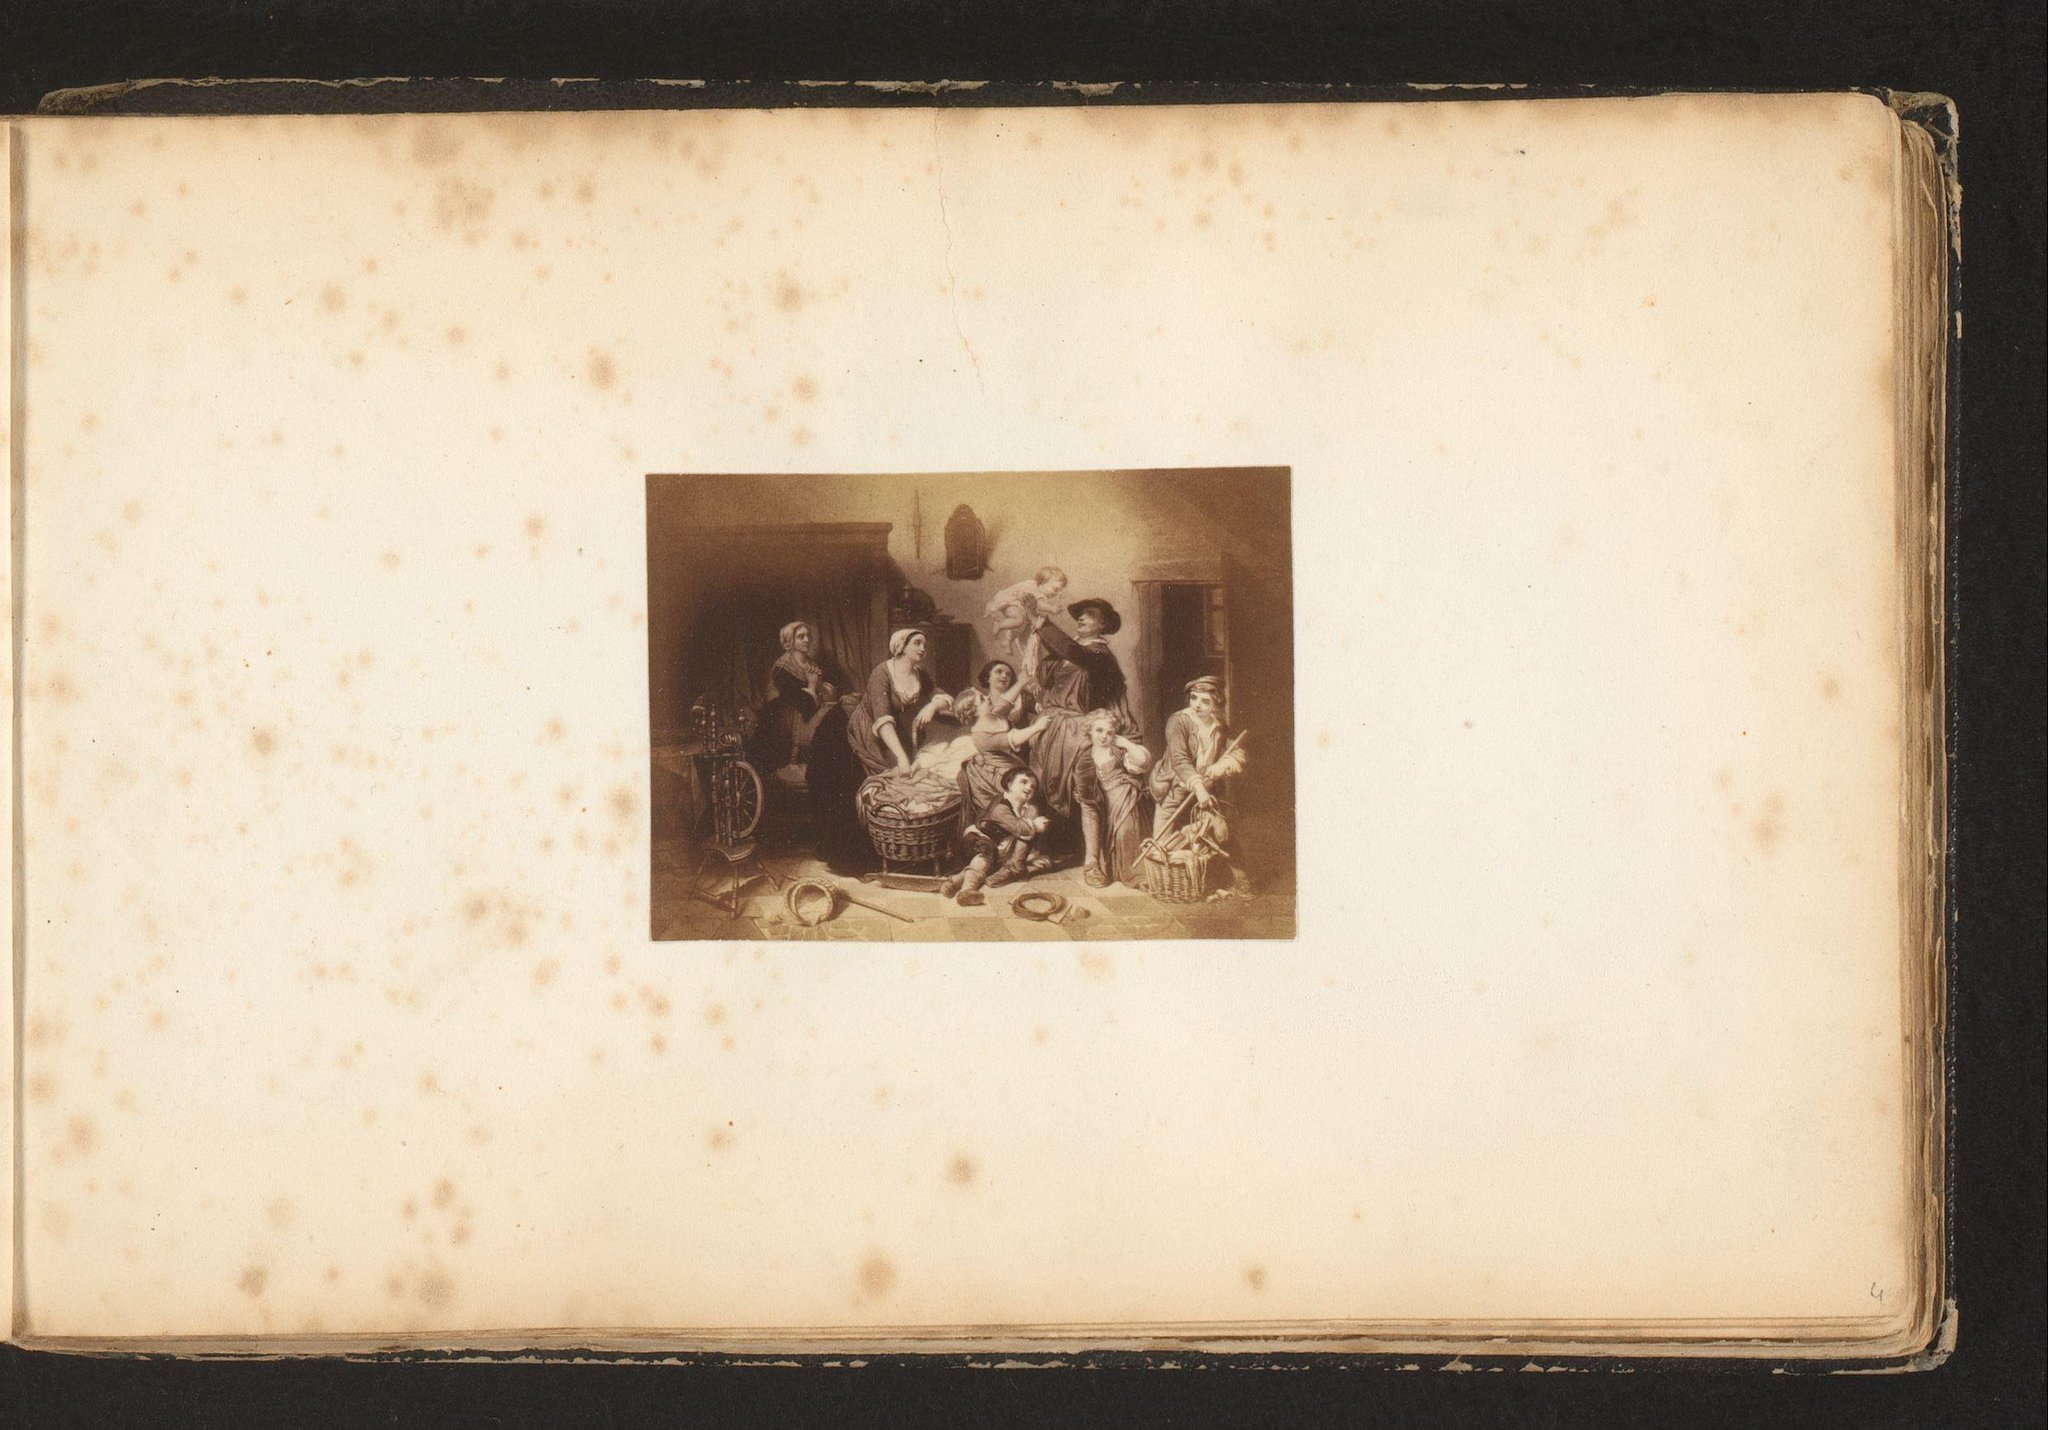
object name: reproduction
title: Fotoreproductie van een schilderij van een huishouden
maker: Anonymous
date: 1860-1900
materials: photographic support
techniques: albumen print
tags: spinning-wheel, family life, interior of the house, painting, drawing and the graphic arts